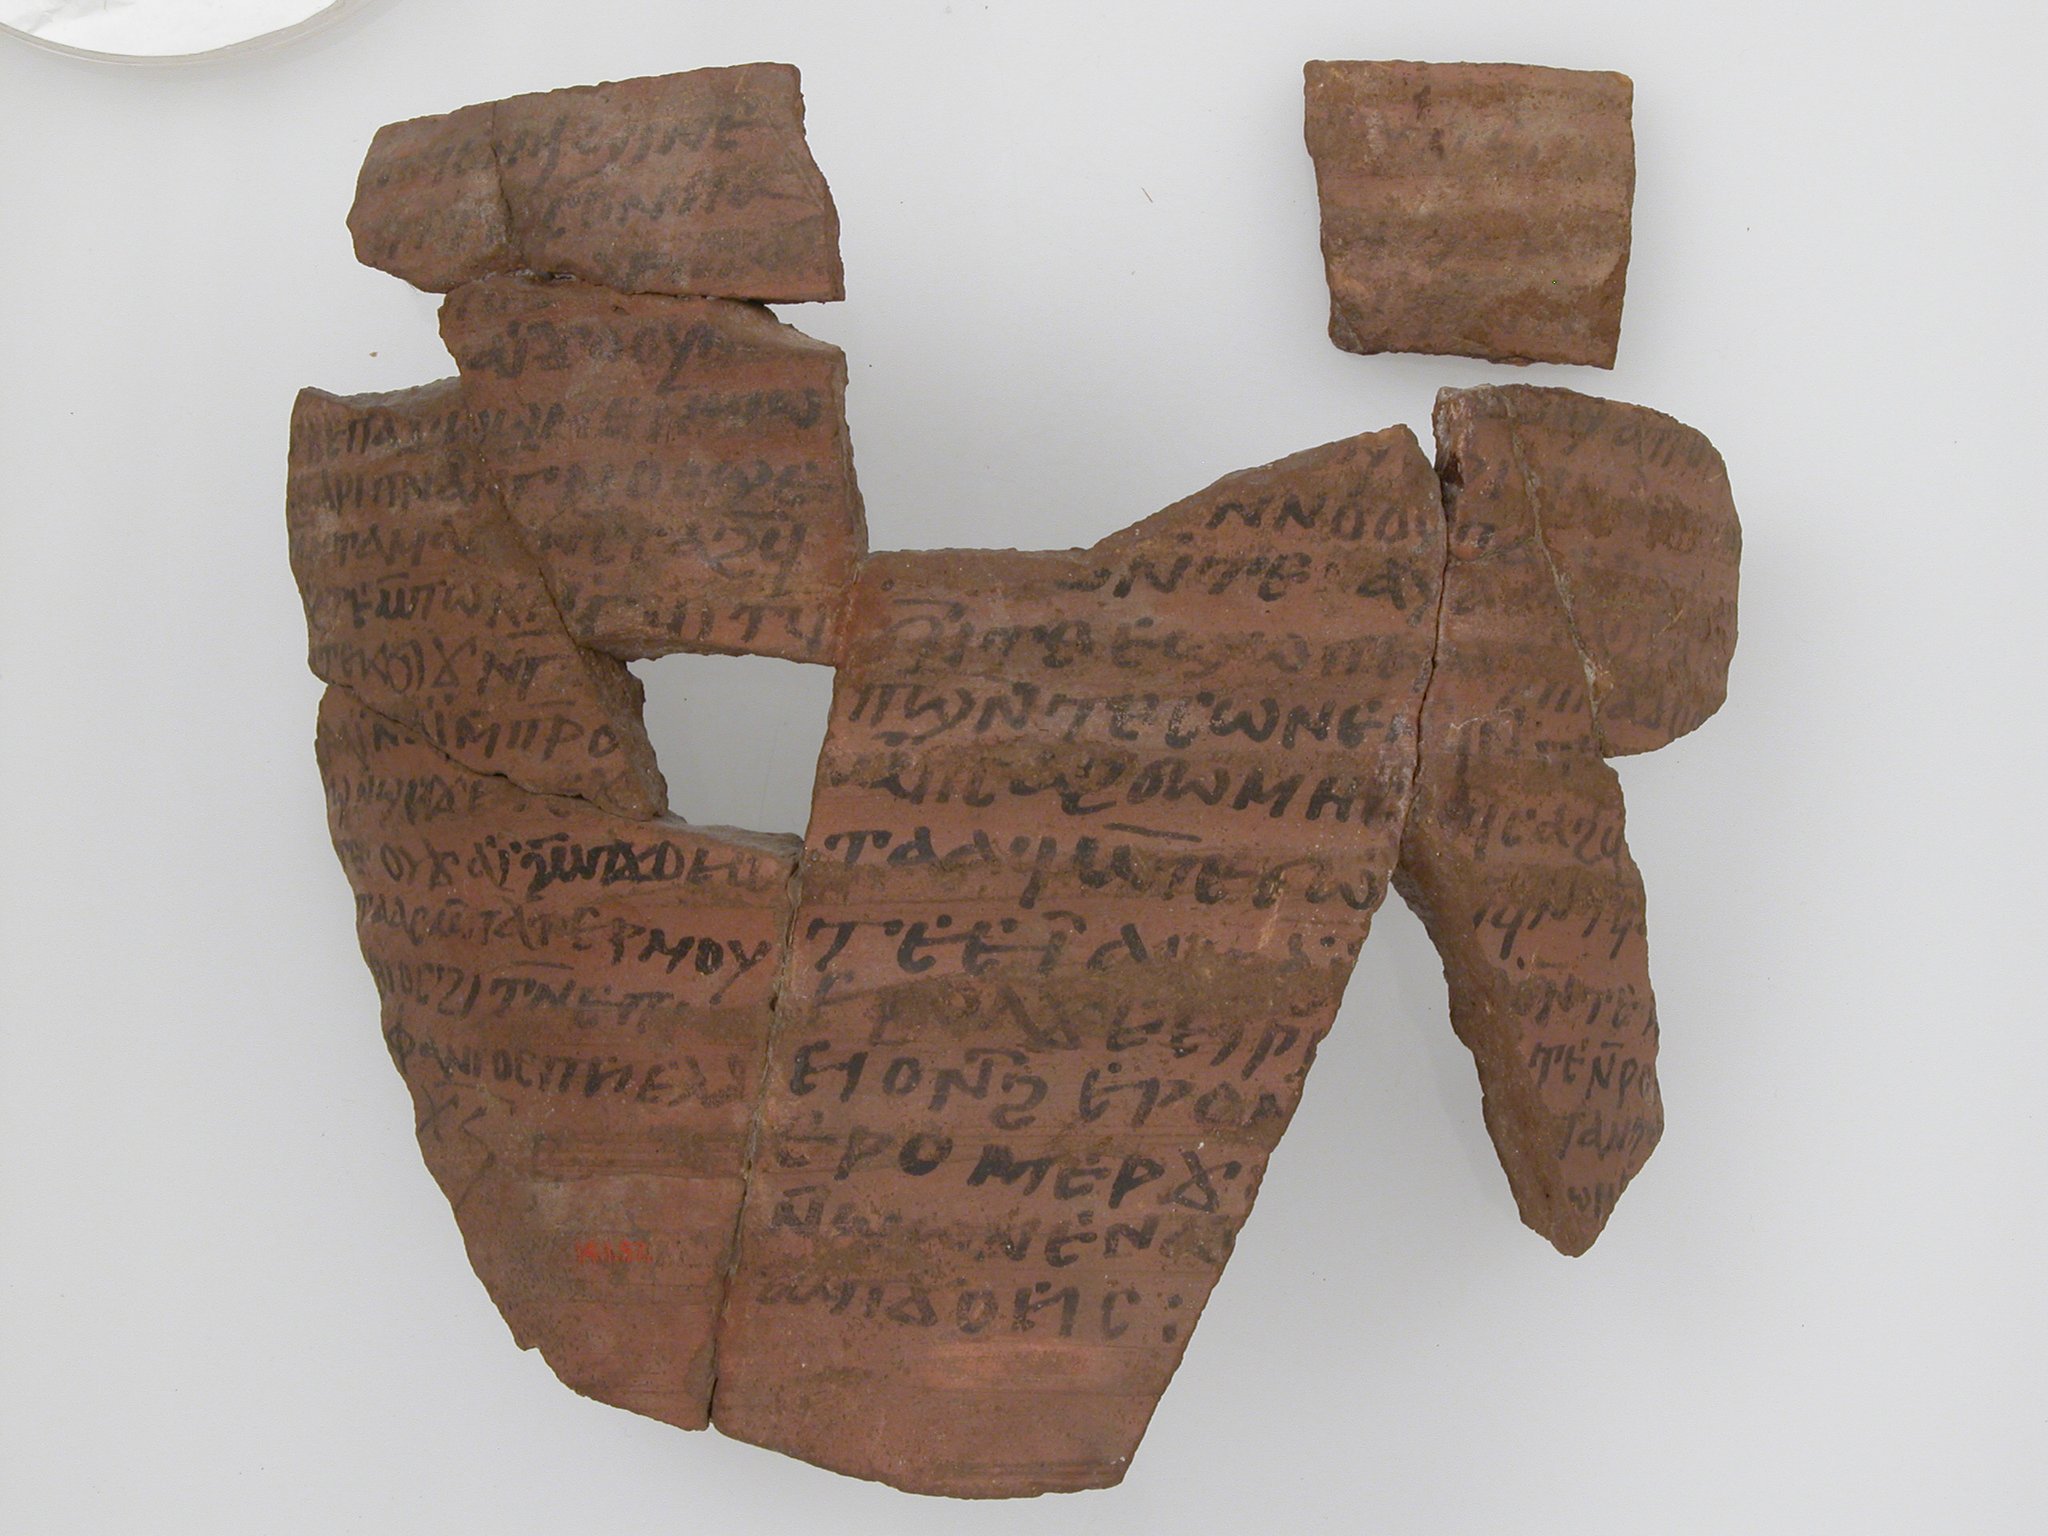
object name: ostrakon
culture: coptic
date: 600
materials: ink, pottery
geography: egypt